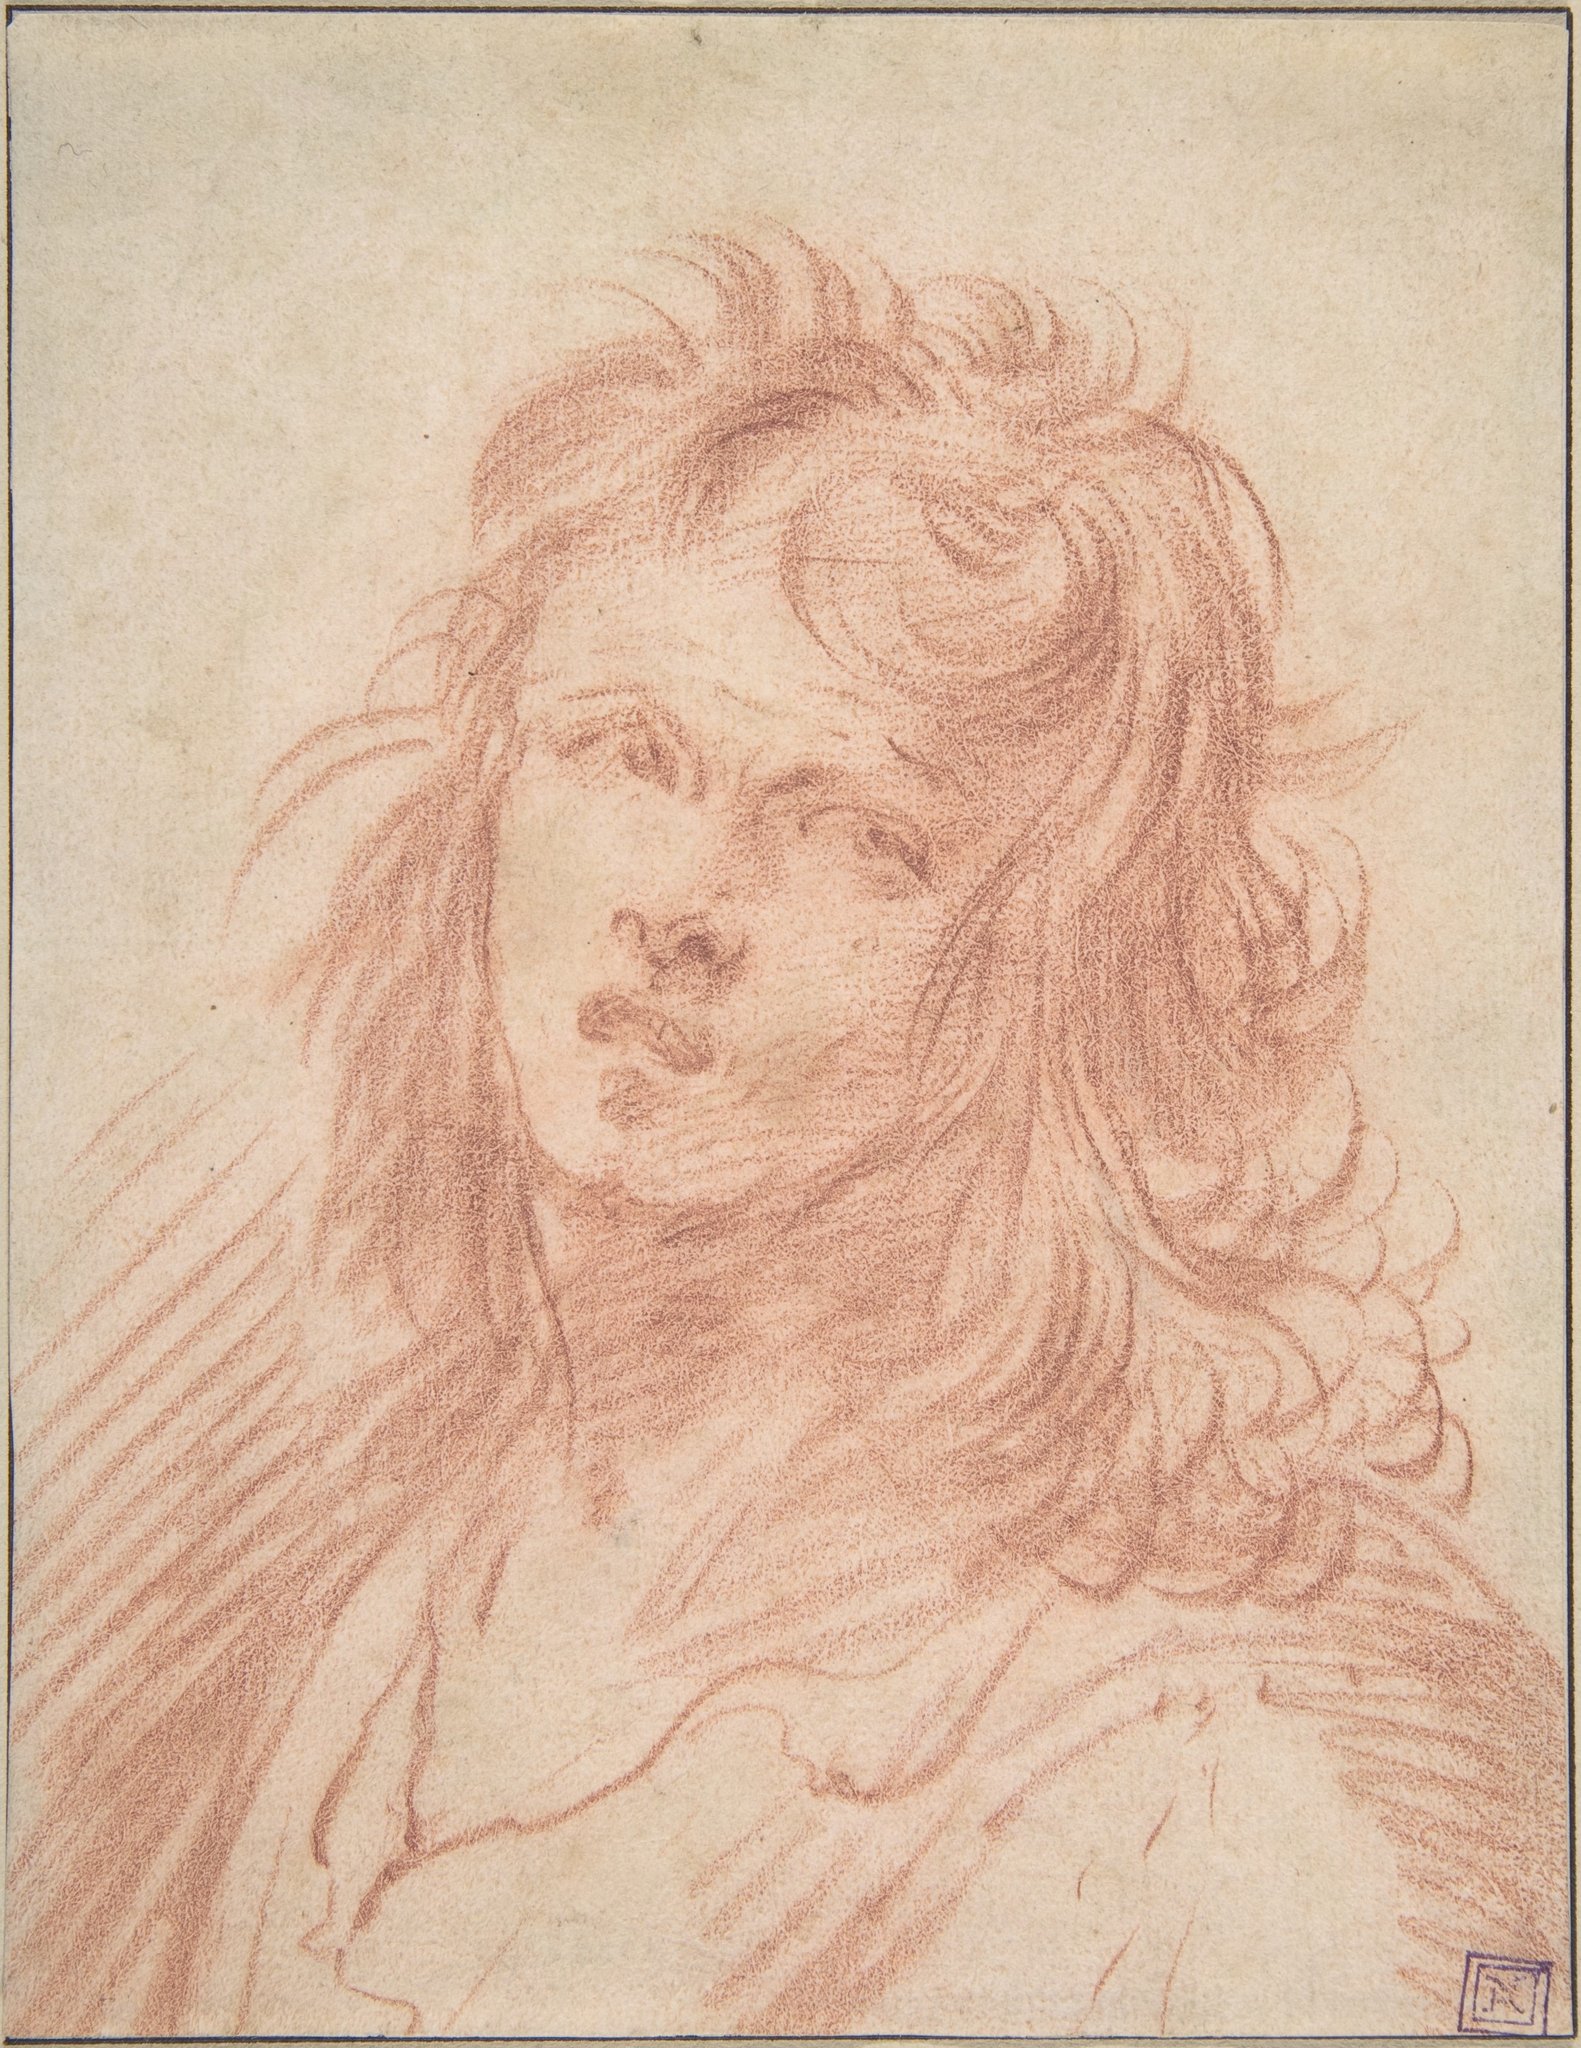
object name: drawing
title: Bust of a Young Man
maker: jean de saint-igny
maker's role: artist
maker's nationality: french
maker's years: 1595-1647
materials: chalk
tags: men,portraits